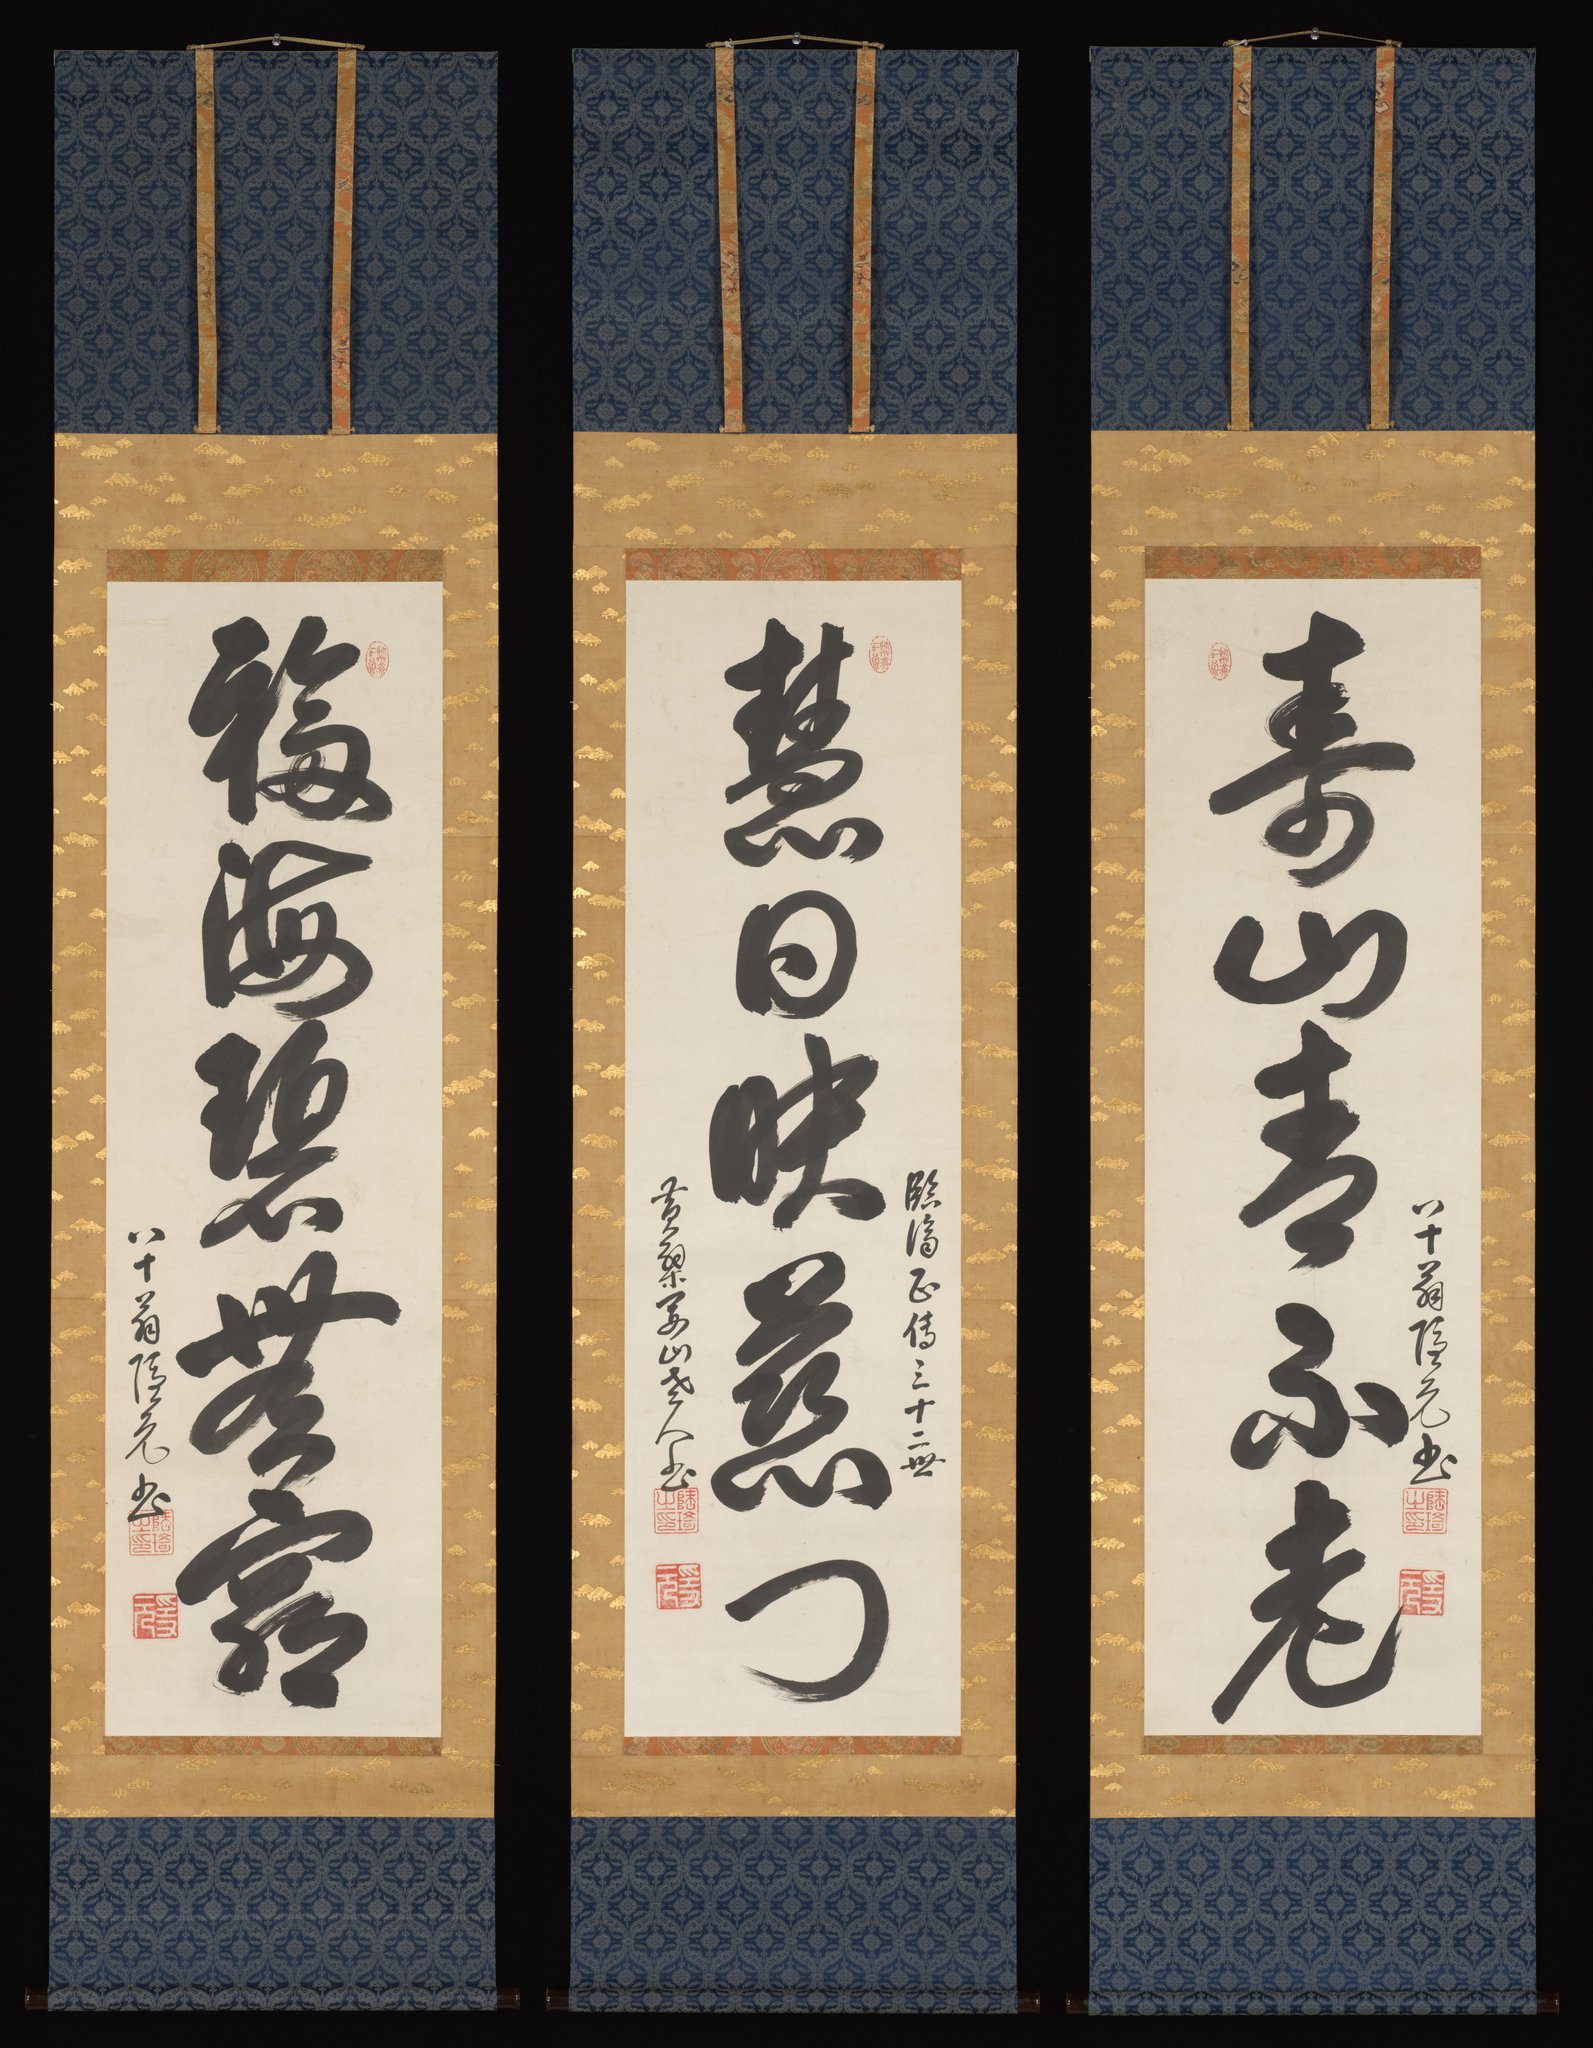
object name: hanging scroll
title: Triptych of One-Column Calligraphies on Auspicious Natural Imagery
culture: japanese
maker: yinyuan longqi (ingen ryūki)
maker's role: artist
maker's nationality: chinese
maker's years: 1592-1673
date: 1671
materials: ink, paper